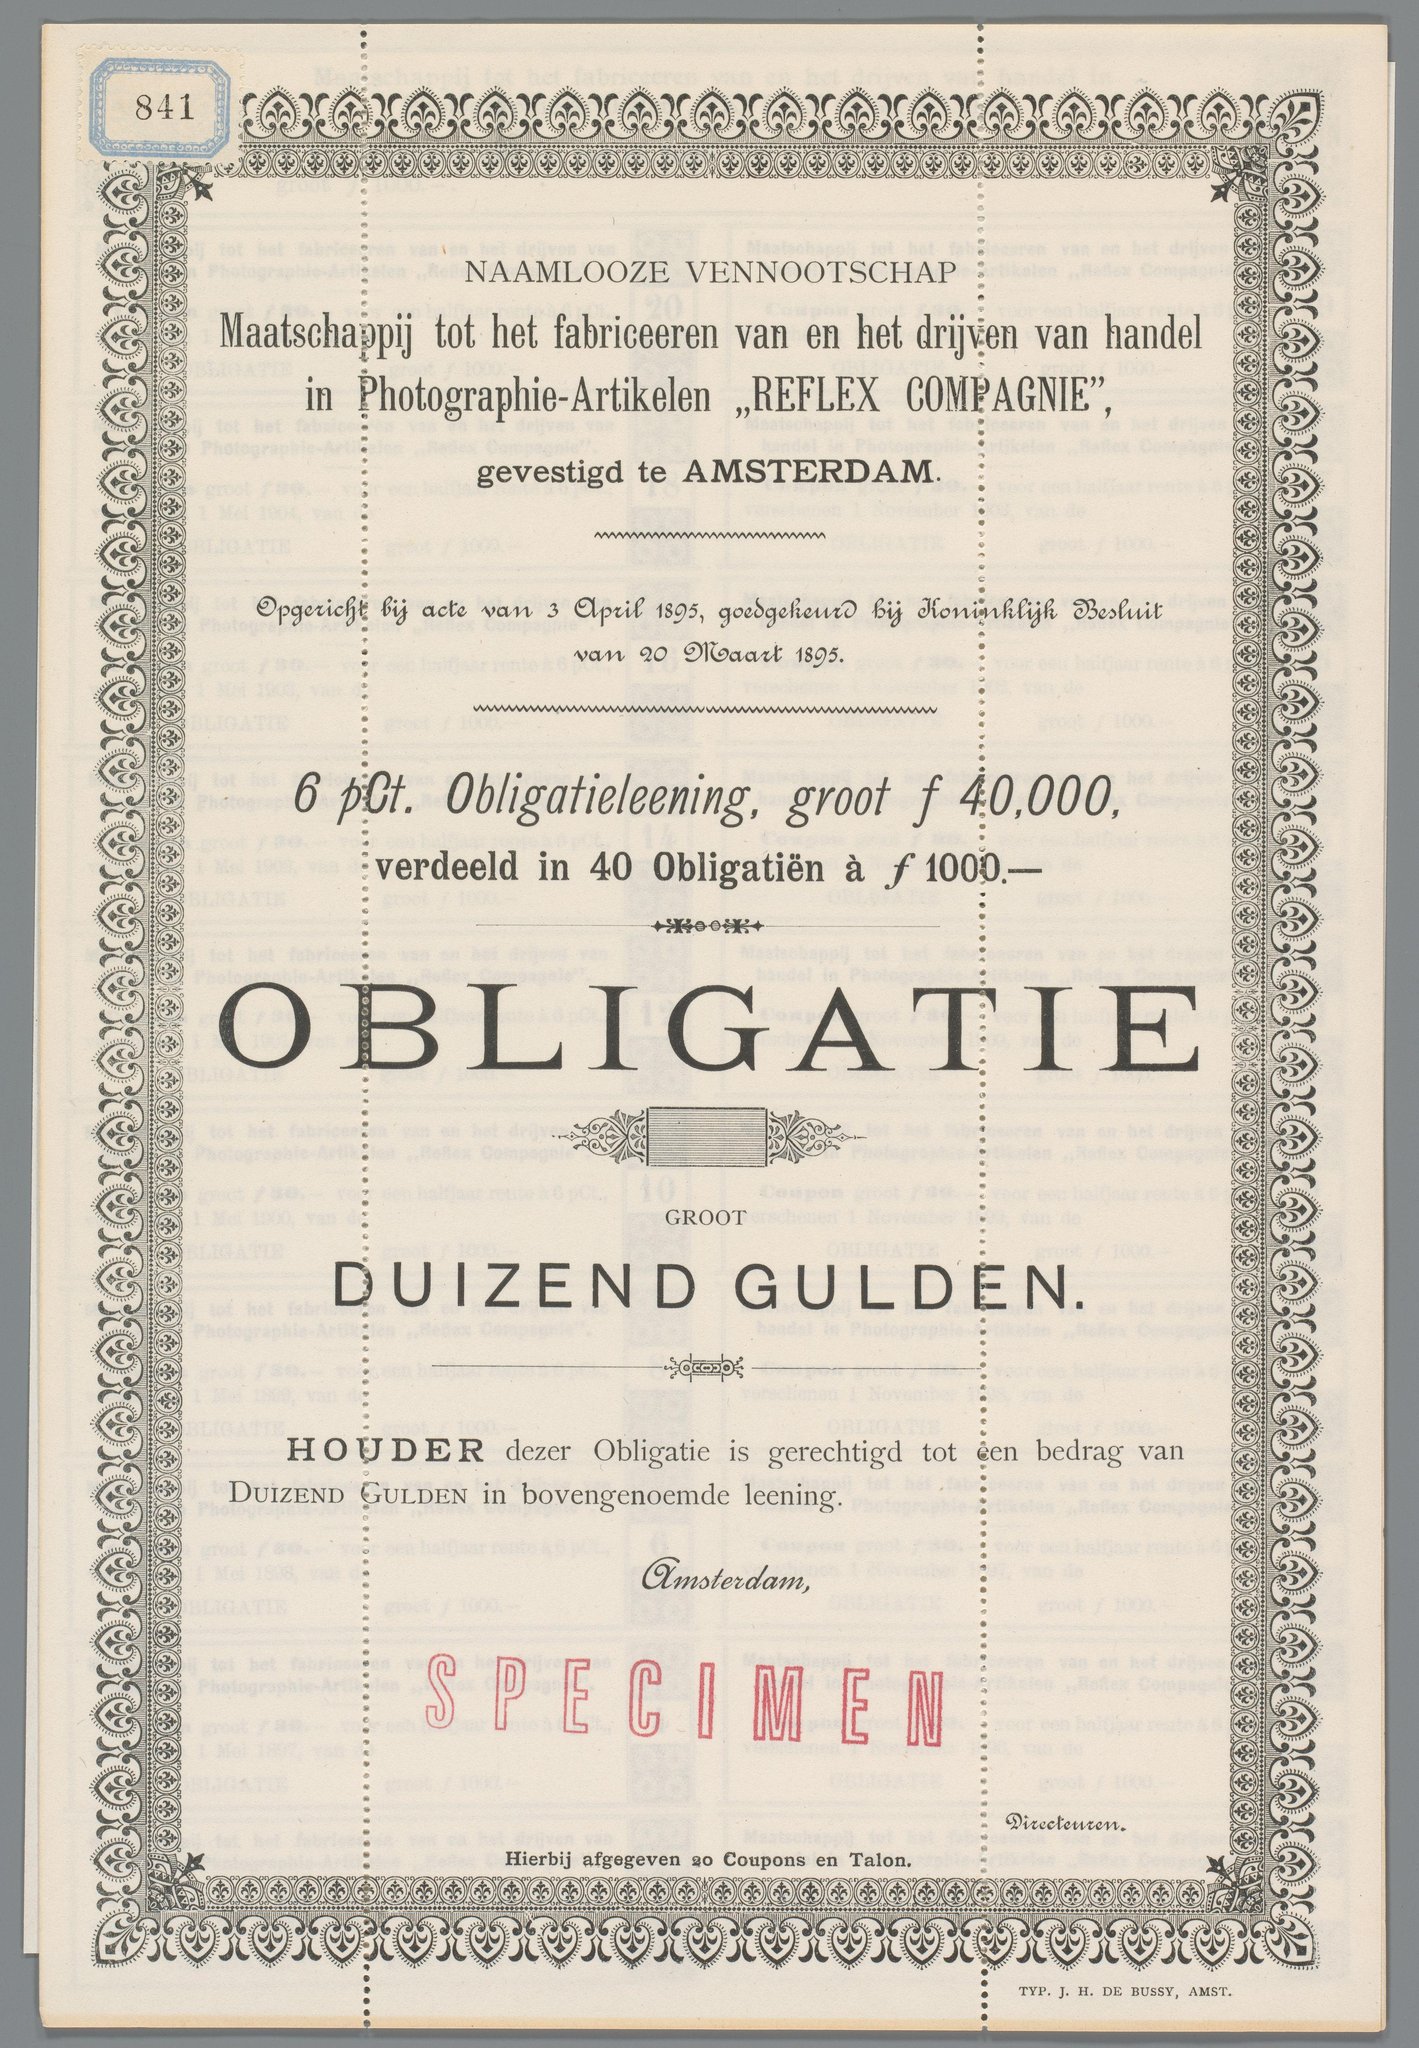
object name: document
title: Obligatie voor het bekostigen van een lening voor Reflex Compagnie ter waarde van duizend gulden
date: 1895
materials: paper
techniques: printing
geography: amsterdam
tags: stock exchange, stock-market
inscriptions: stamp: ‘SPECIMEN’, number: ‘841’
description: Obligatie met specimen-opdruk voor de naamloze vennootschap 'Maatschappij tot het fabriceeren van en het drijven van handel in Photographie-Artikelen Reflex Compagnie', gevestigd in Amsterdam. De obligatie bestaat uit een mantel en couponblad met daarop 20 coupons.